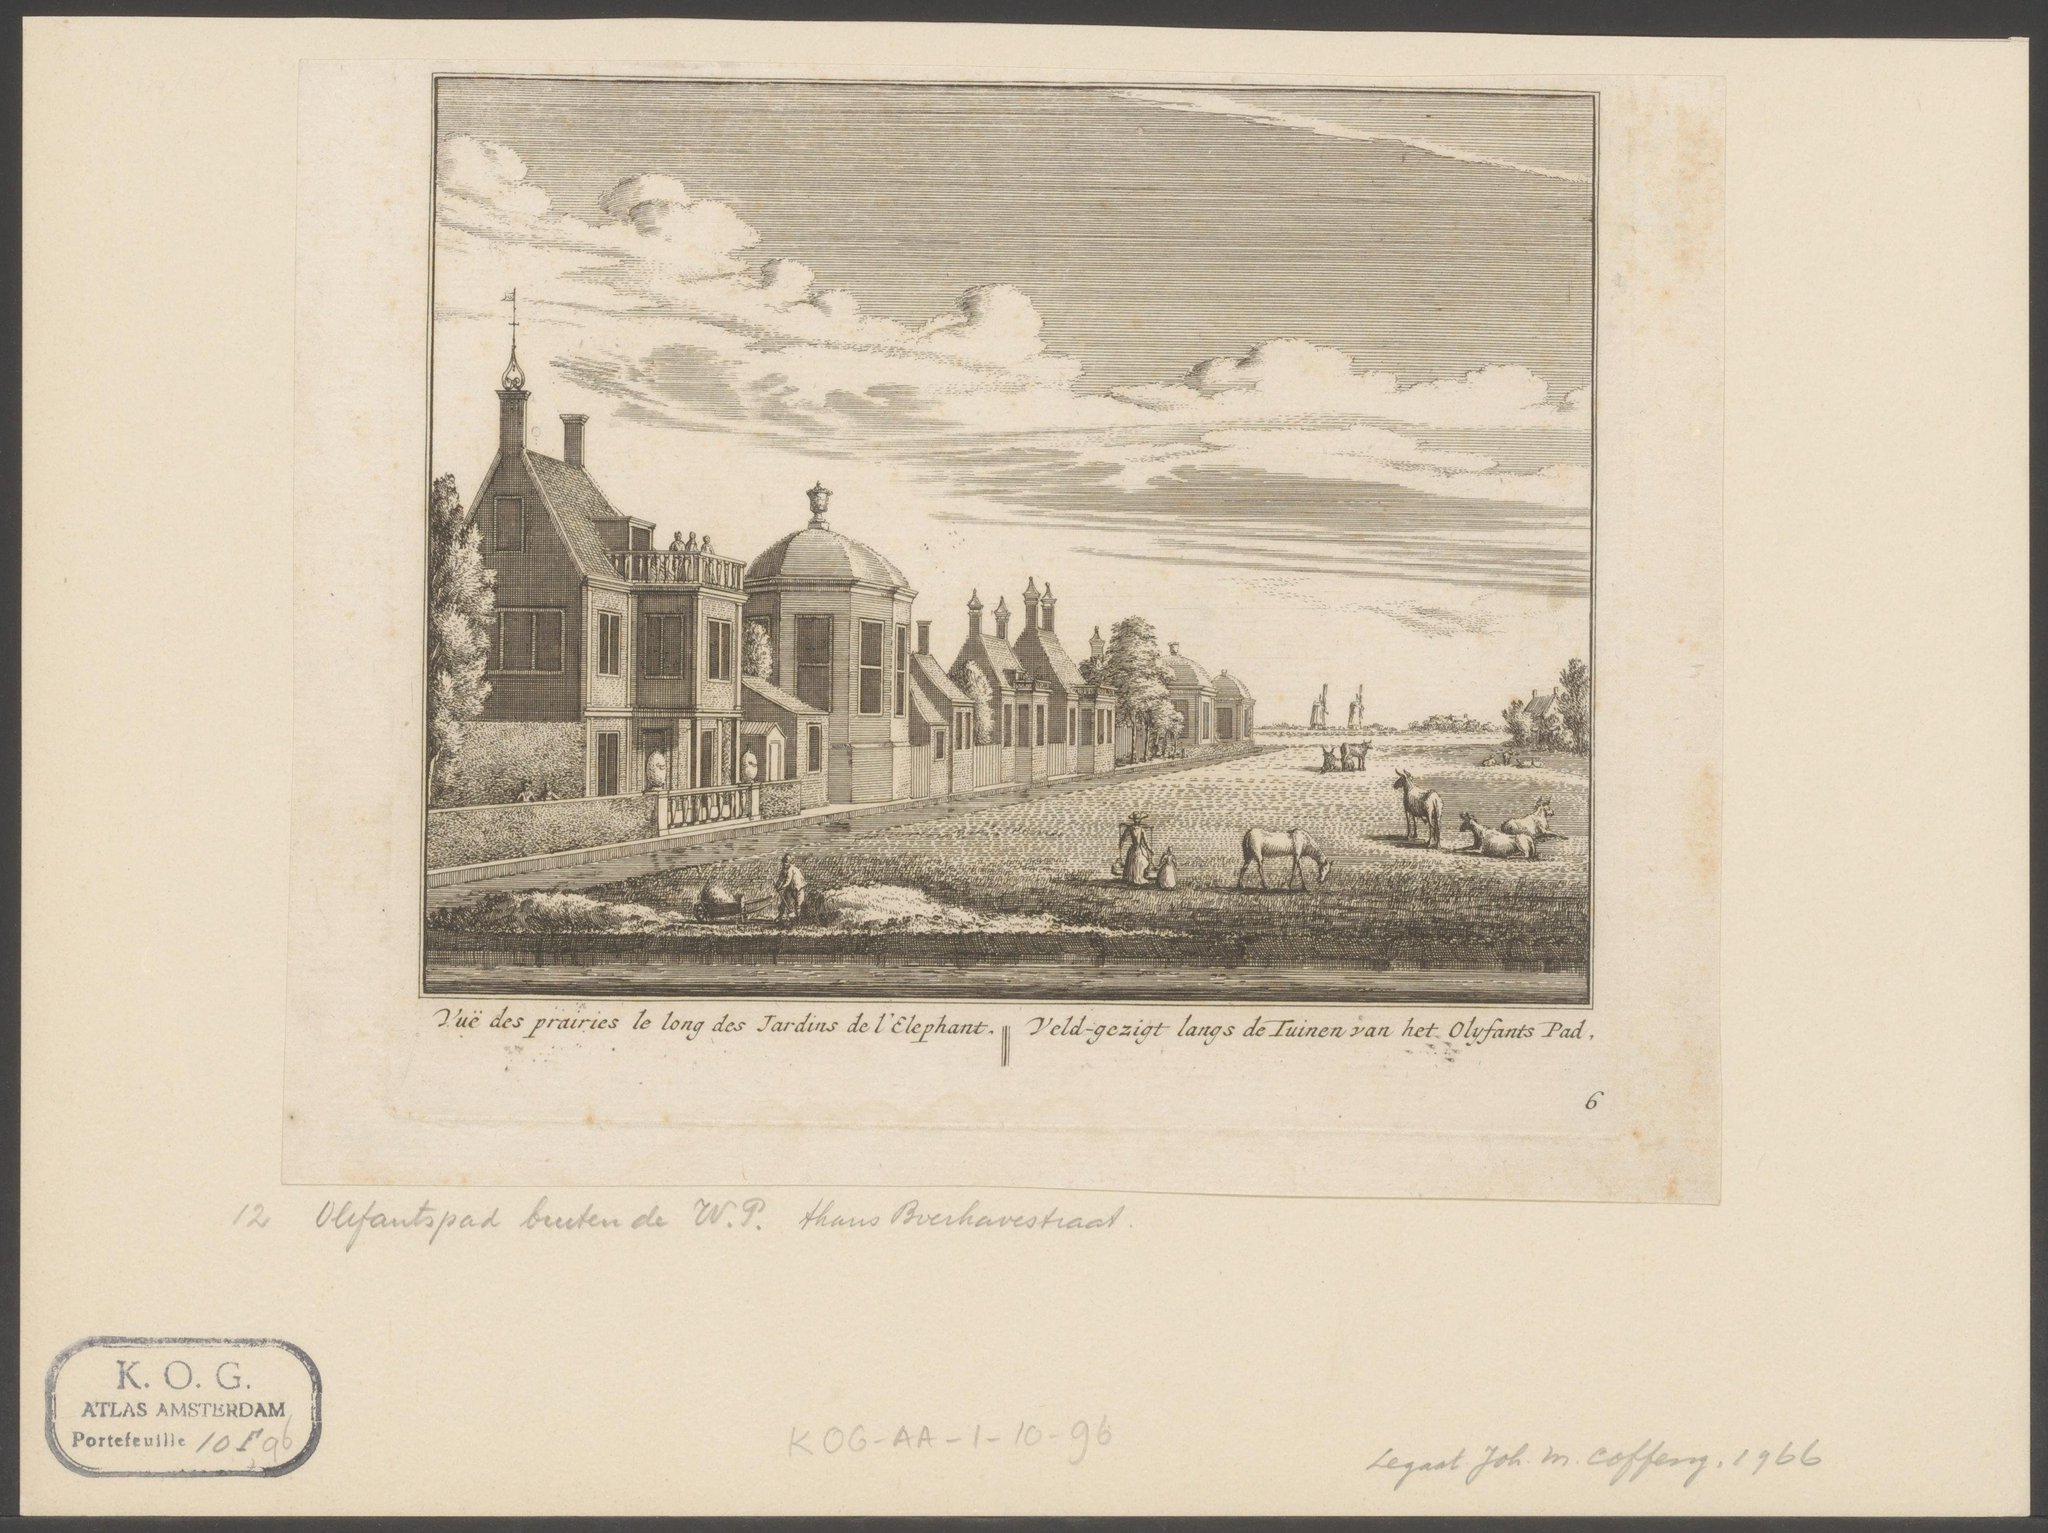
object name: print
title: Gezicht op de achterzijde van bebouwing aan de Weesperzijde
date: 1730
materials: paper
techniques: etching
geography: amsterdam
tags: city-view in general; 'veduta', rear façade, the usual house or row of houses, bovine cattle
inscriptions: inscription: ‘12 Olifantspad buiten (...) Joh. M. Coffeng. 1966’, collector's mark: ‘10F96’ Lugt 1641b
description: Onderwerpsrubriek binnen de Atlas Amsterdam: Oetgensstraat, Olifantspad, Olofspoort (St.), Onkelboerensteeg, Oosterparkstraat, Oostenburgergracht, Oosterdoksdijk, Osjessluis en Kalverstraat, Ossenspooksteeg, Oudekerksplein, Oudemanhuispoort, Oude Schans. Rechtsonder genummerd: 6.